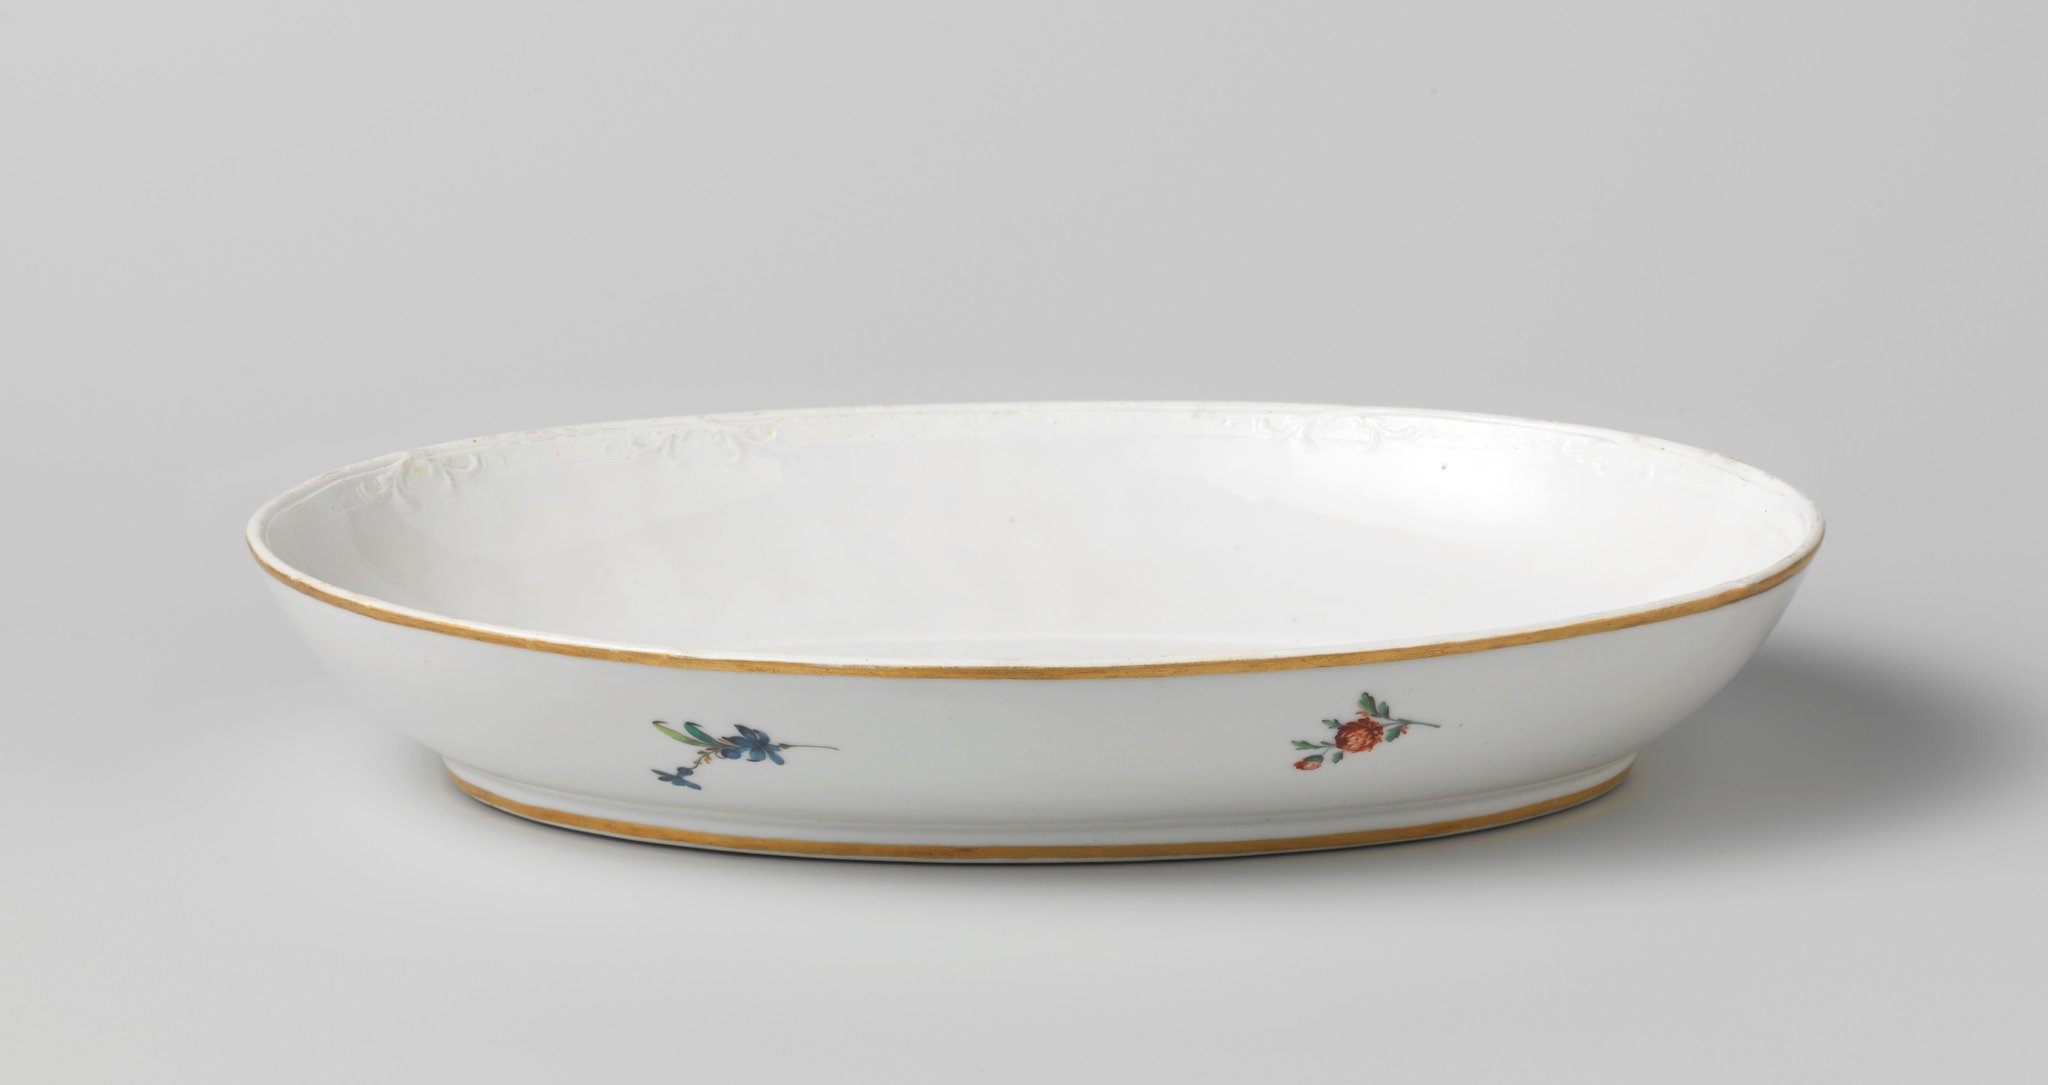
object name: dish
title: Schaal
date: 1784-1814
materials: porcelain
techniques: painted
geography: amstel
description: Ovale schaal veelkleurig beschilderd met strooibloemen met gestileerde bladeren in relief. Gemerkt: Amstel.